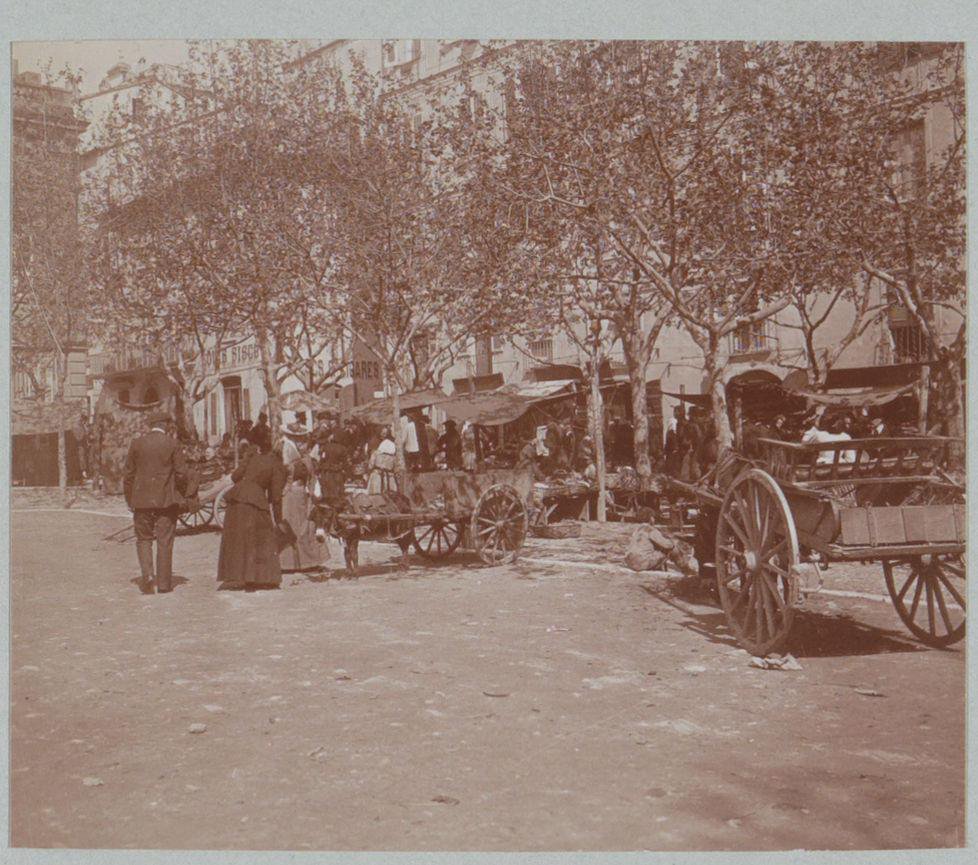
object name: photograph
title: Plein met markt en ezelkarren, vermoedelijk op Corsica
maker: Anonymous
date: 1905-1910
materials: paper, photographic support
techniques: gelatin silver print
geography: bastia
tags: ass, donkey, market, square, place, circus, etc. (+ city(-scape) with figures, staffage)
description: Onderdeel van Fotoalbum van een Franse amateurfotograaf met bezienswaardigheden in Frankrijk, Zwitserland en Italië.